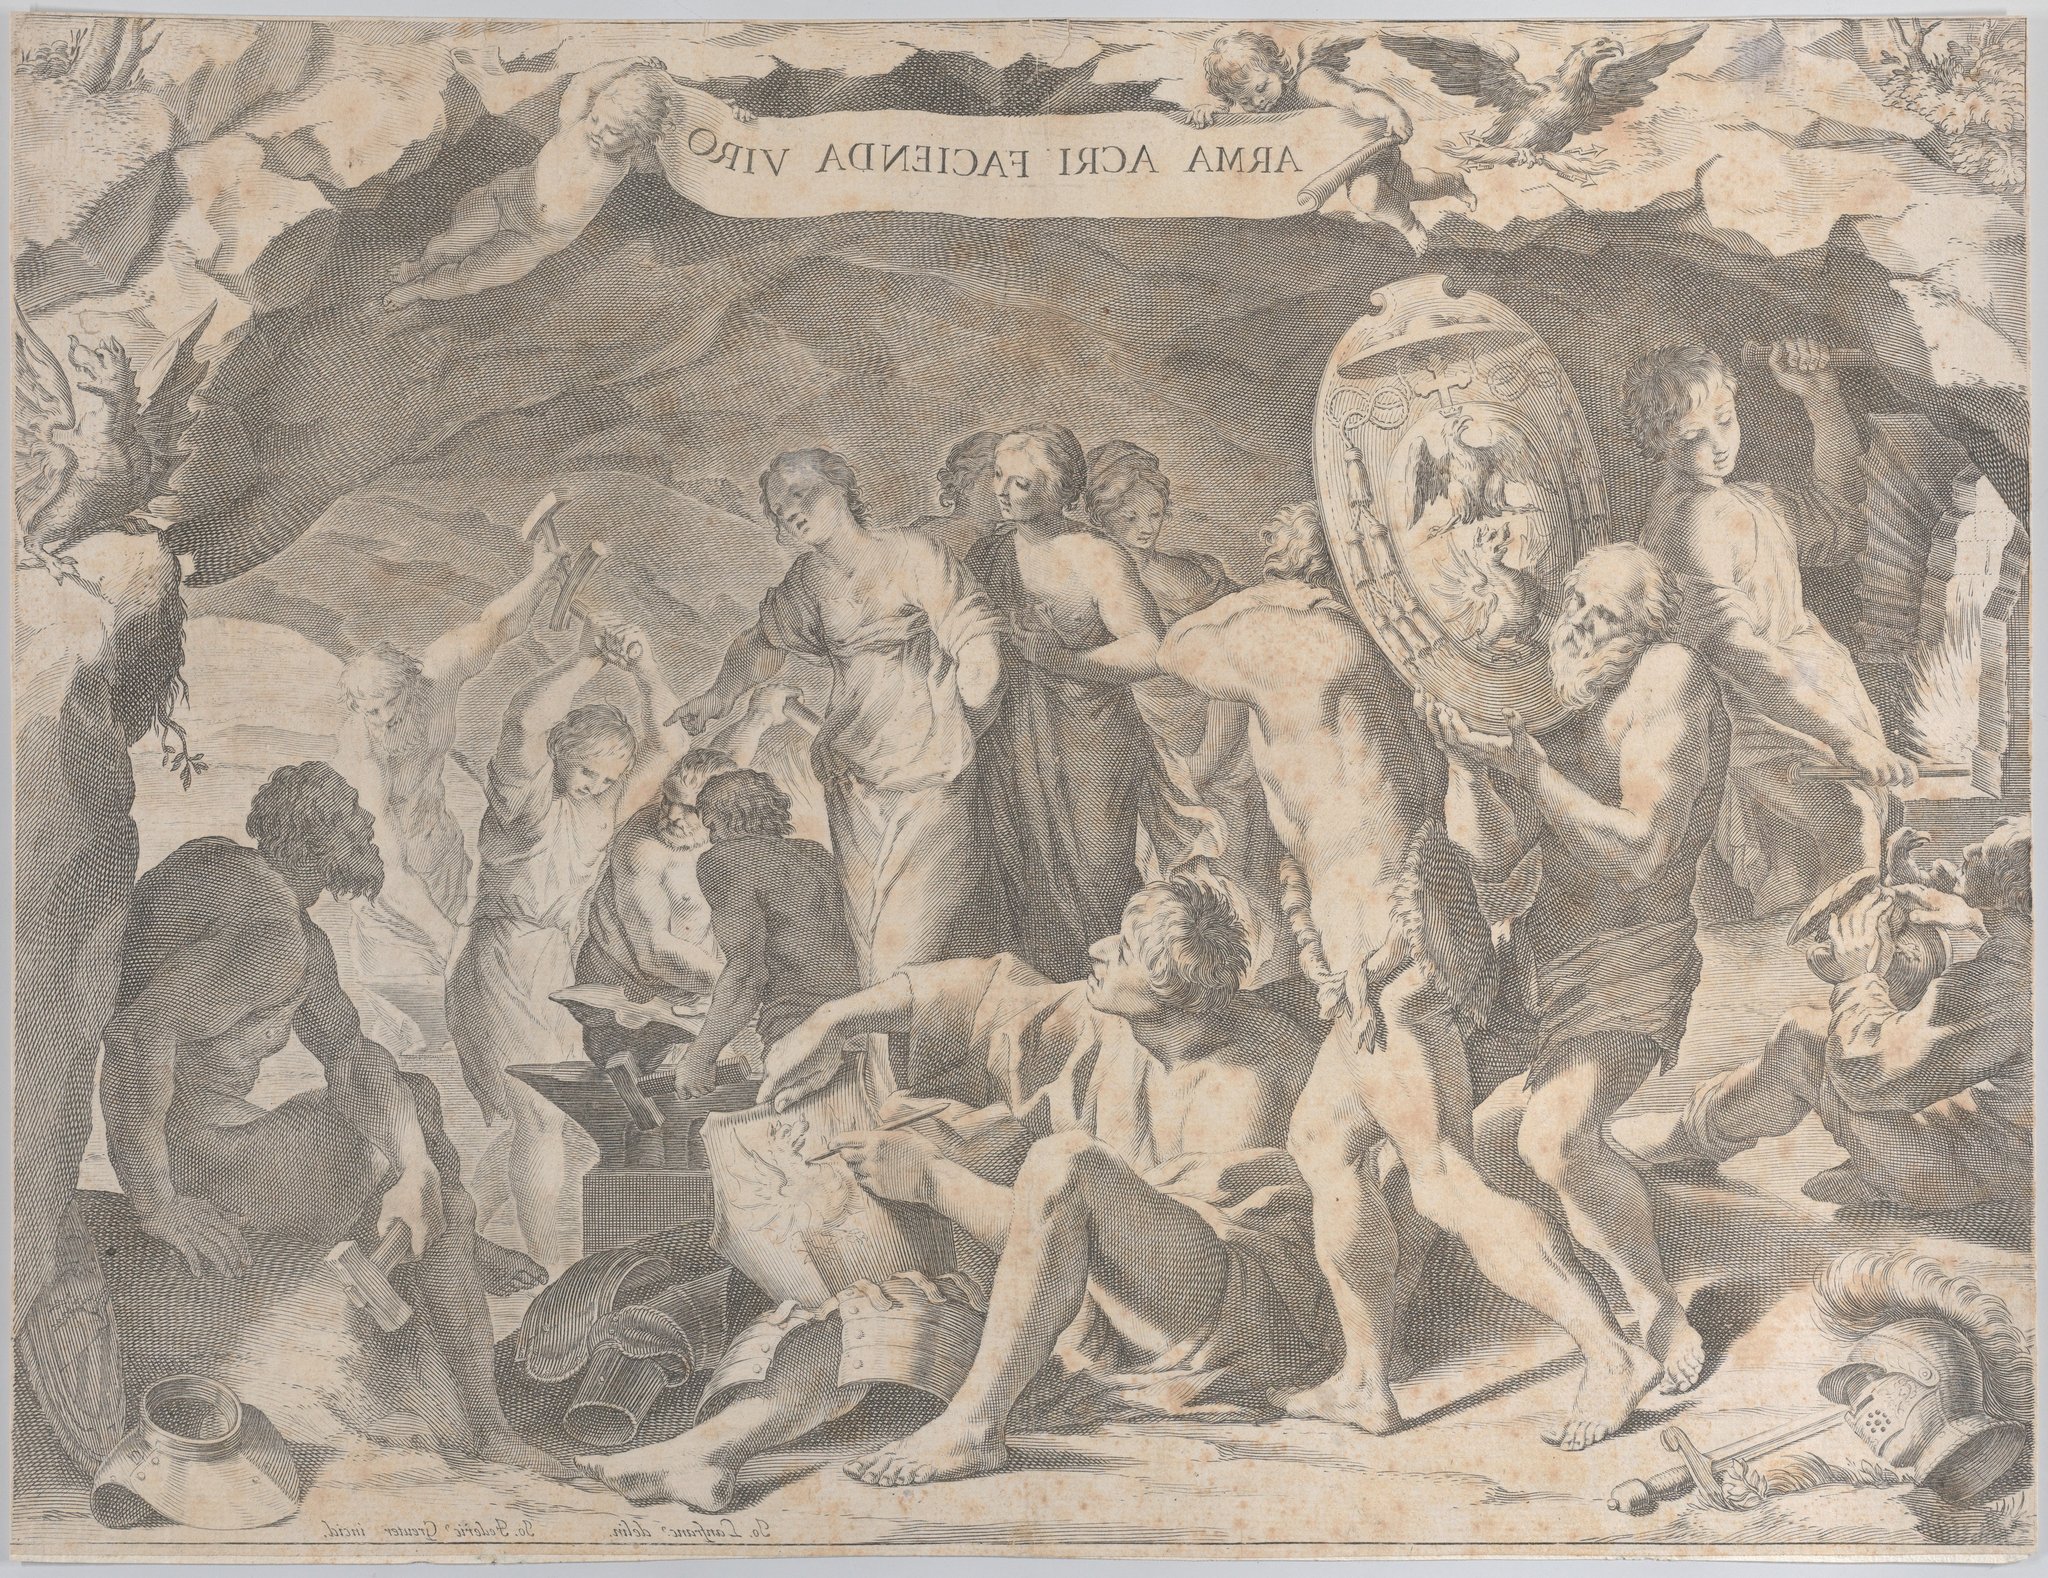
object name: print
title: The Forge of Vulcan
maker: johann friedrich greuter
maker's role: artist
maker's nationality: german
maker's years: 1590-1662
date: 1620-1647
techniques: printmaking, engraving